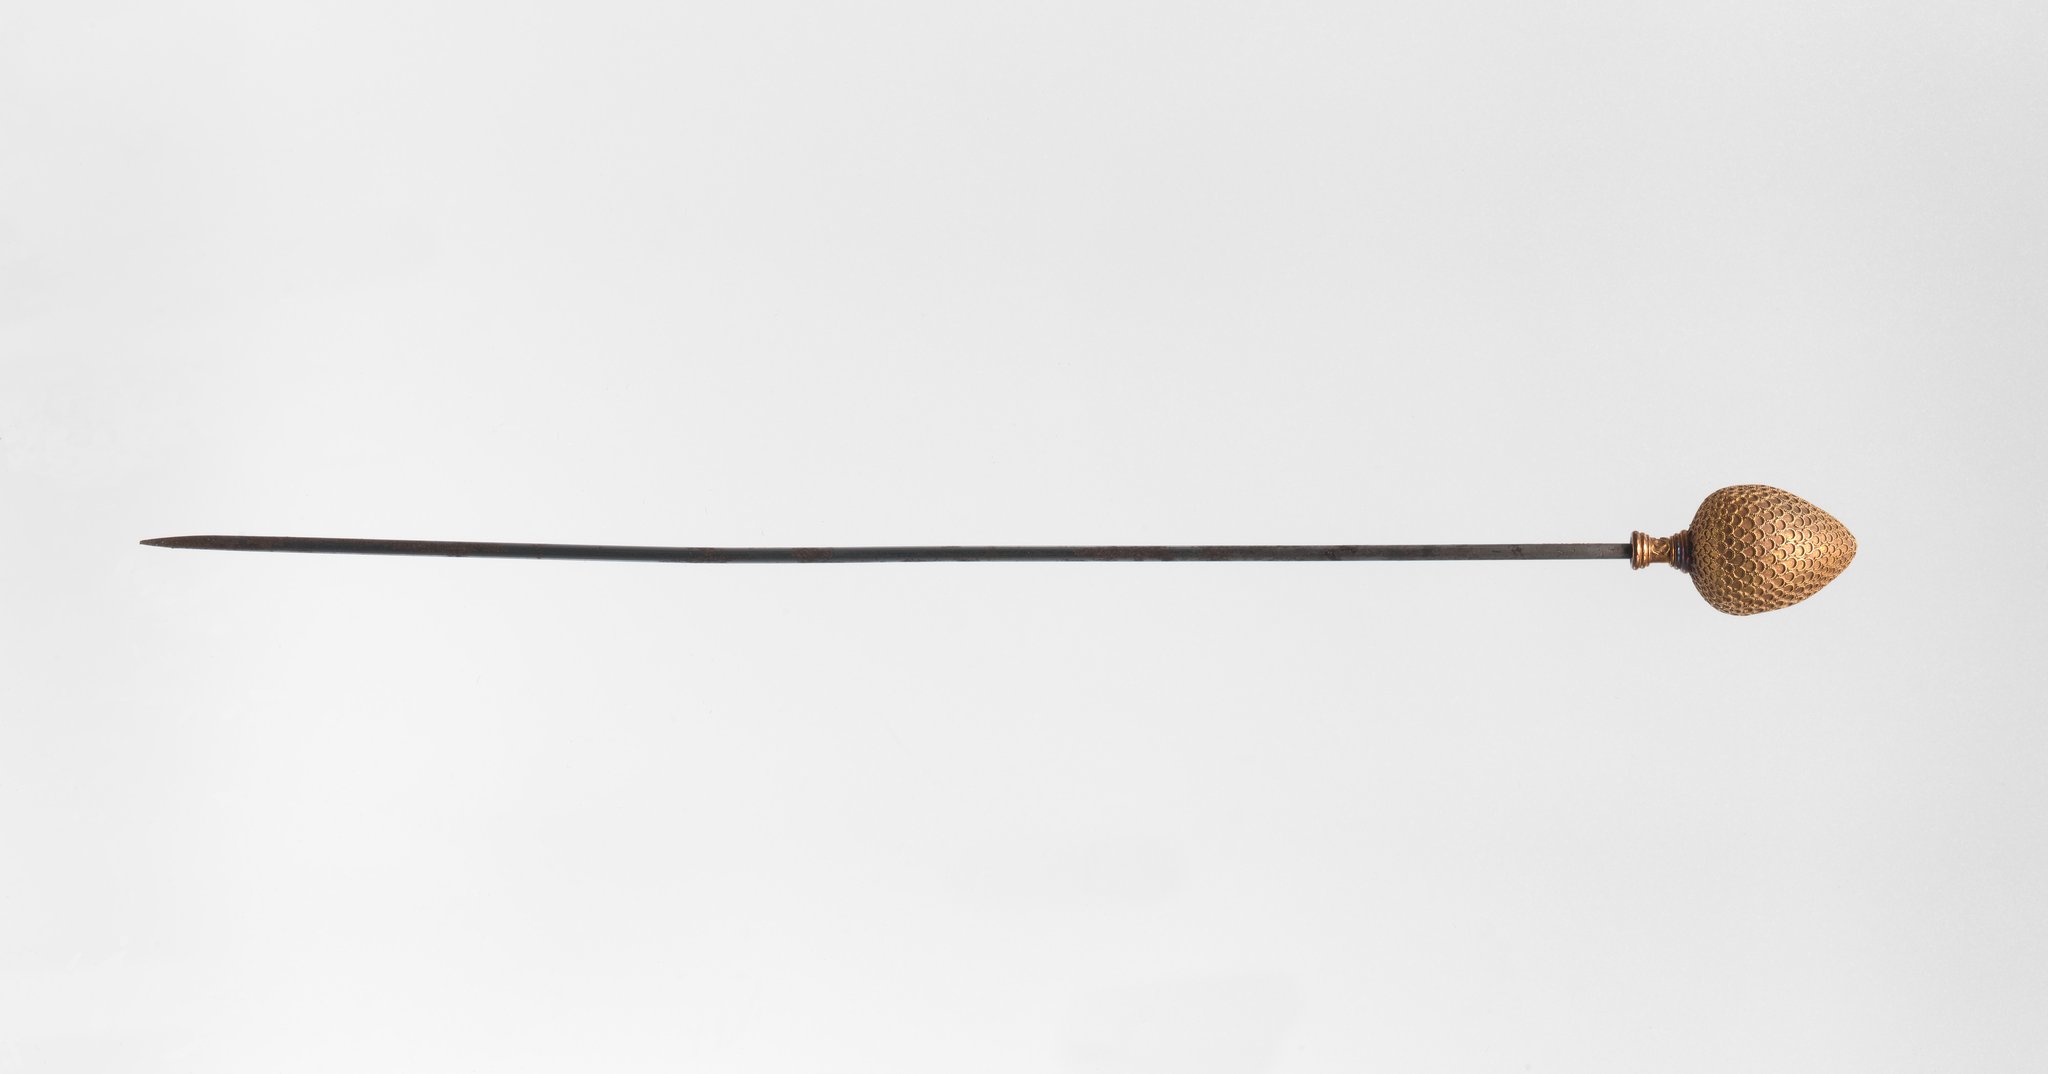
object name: hat pin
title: Archeological-revival hat pin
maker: castellani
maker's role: maker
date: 1880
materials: gold, steel